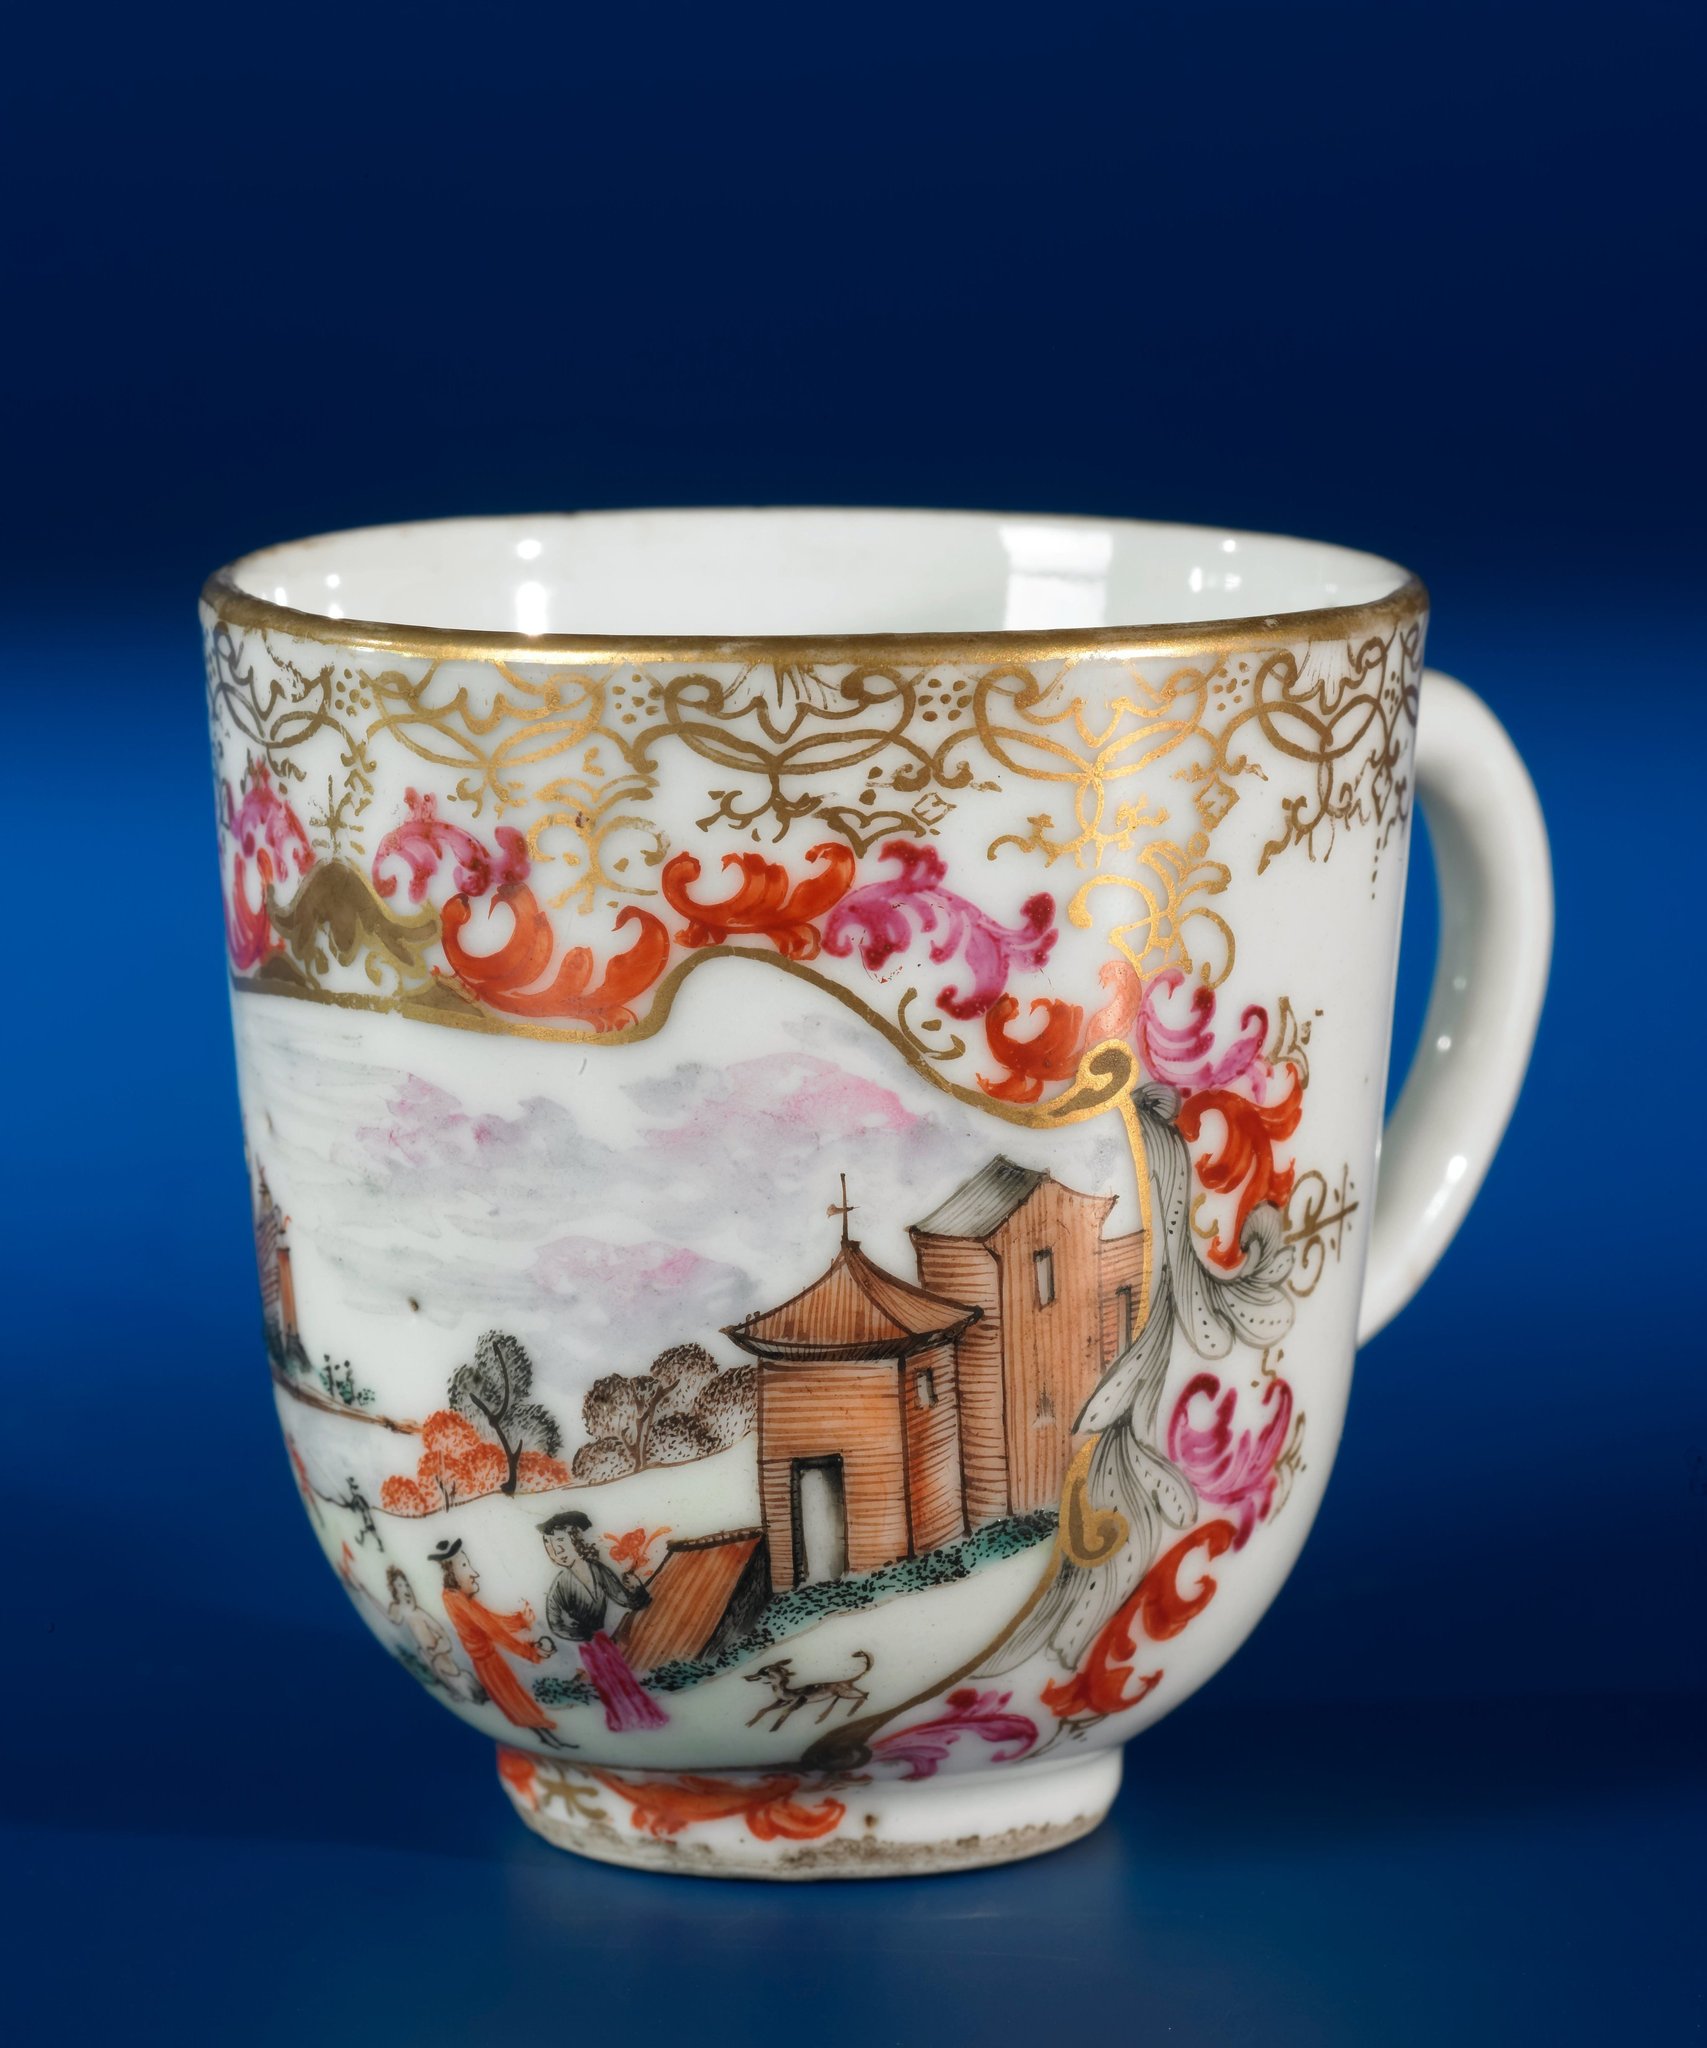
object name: cup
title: Cup with handle with a European waterlandscape in a panel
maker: Anonymous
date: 1740-1760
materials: glaze, gold, paint, porcelain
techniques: firing, gilding, turning, vitrification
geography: china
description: Hoge kop op een voetring, met oor. Gedecoreerd in emailkleuren, met een waterlandschap. Binnen een cartouche zijn verschillende Europese figuurtjes, een kerkje en een hondje afgebeeld, op de achtergrond een groot zeilschip. Rondom een decoratief ornament. De decoratie is ontleend aan Meissen porselein. Dit porselein werd vaak met havengezichten gedecoreerd. In China werd dit (duurdere) Meissen porselein gekopieerd. Het decoratieve patroon dat men vaak aantreft op Meissen porselein is een zich herhalend patroon van krullen en lijnen die door elkaar lopen, meestal in goud geschilderd.